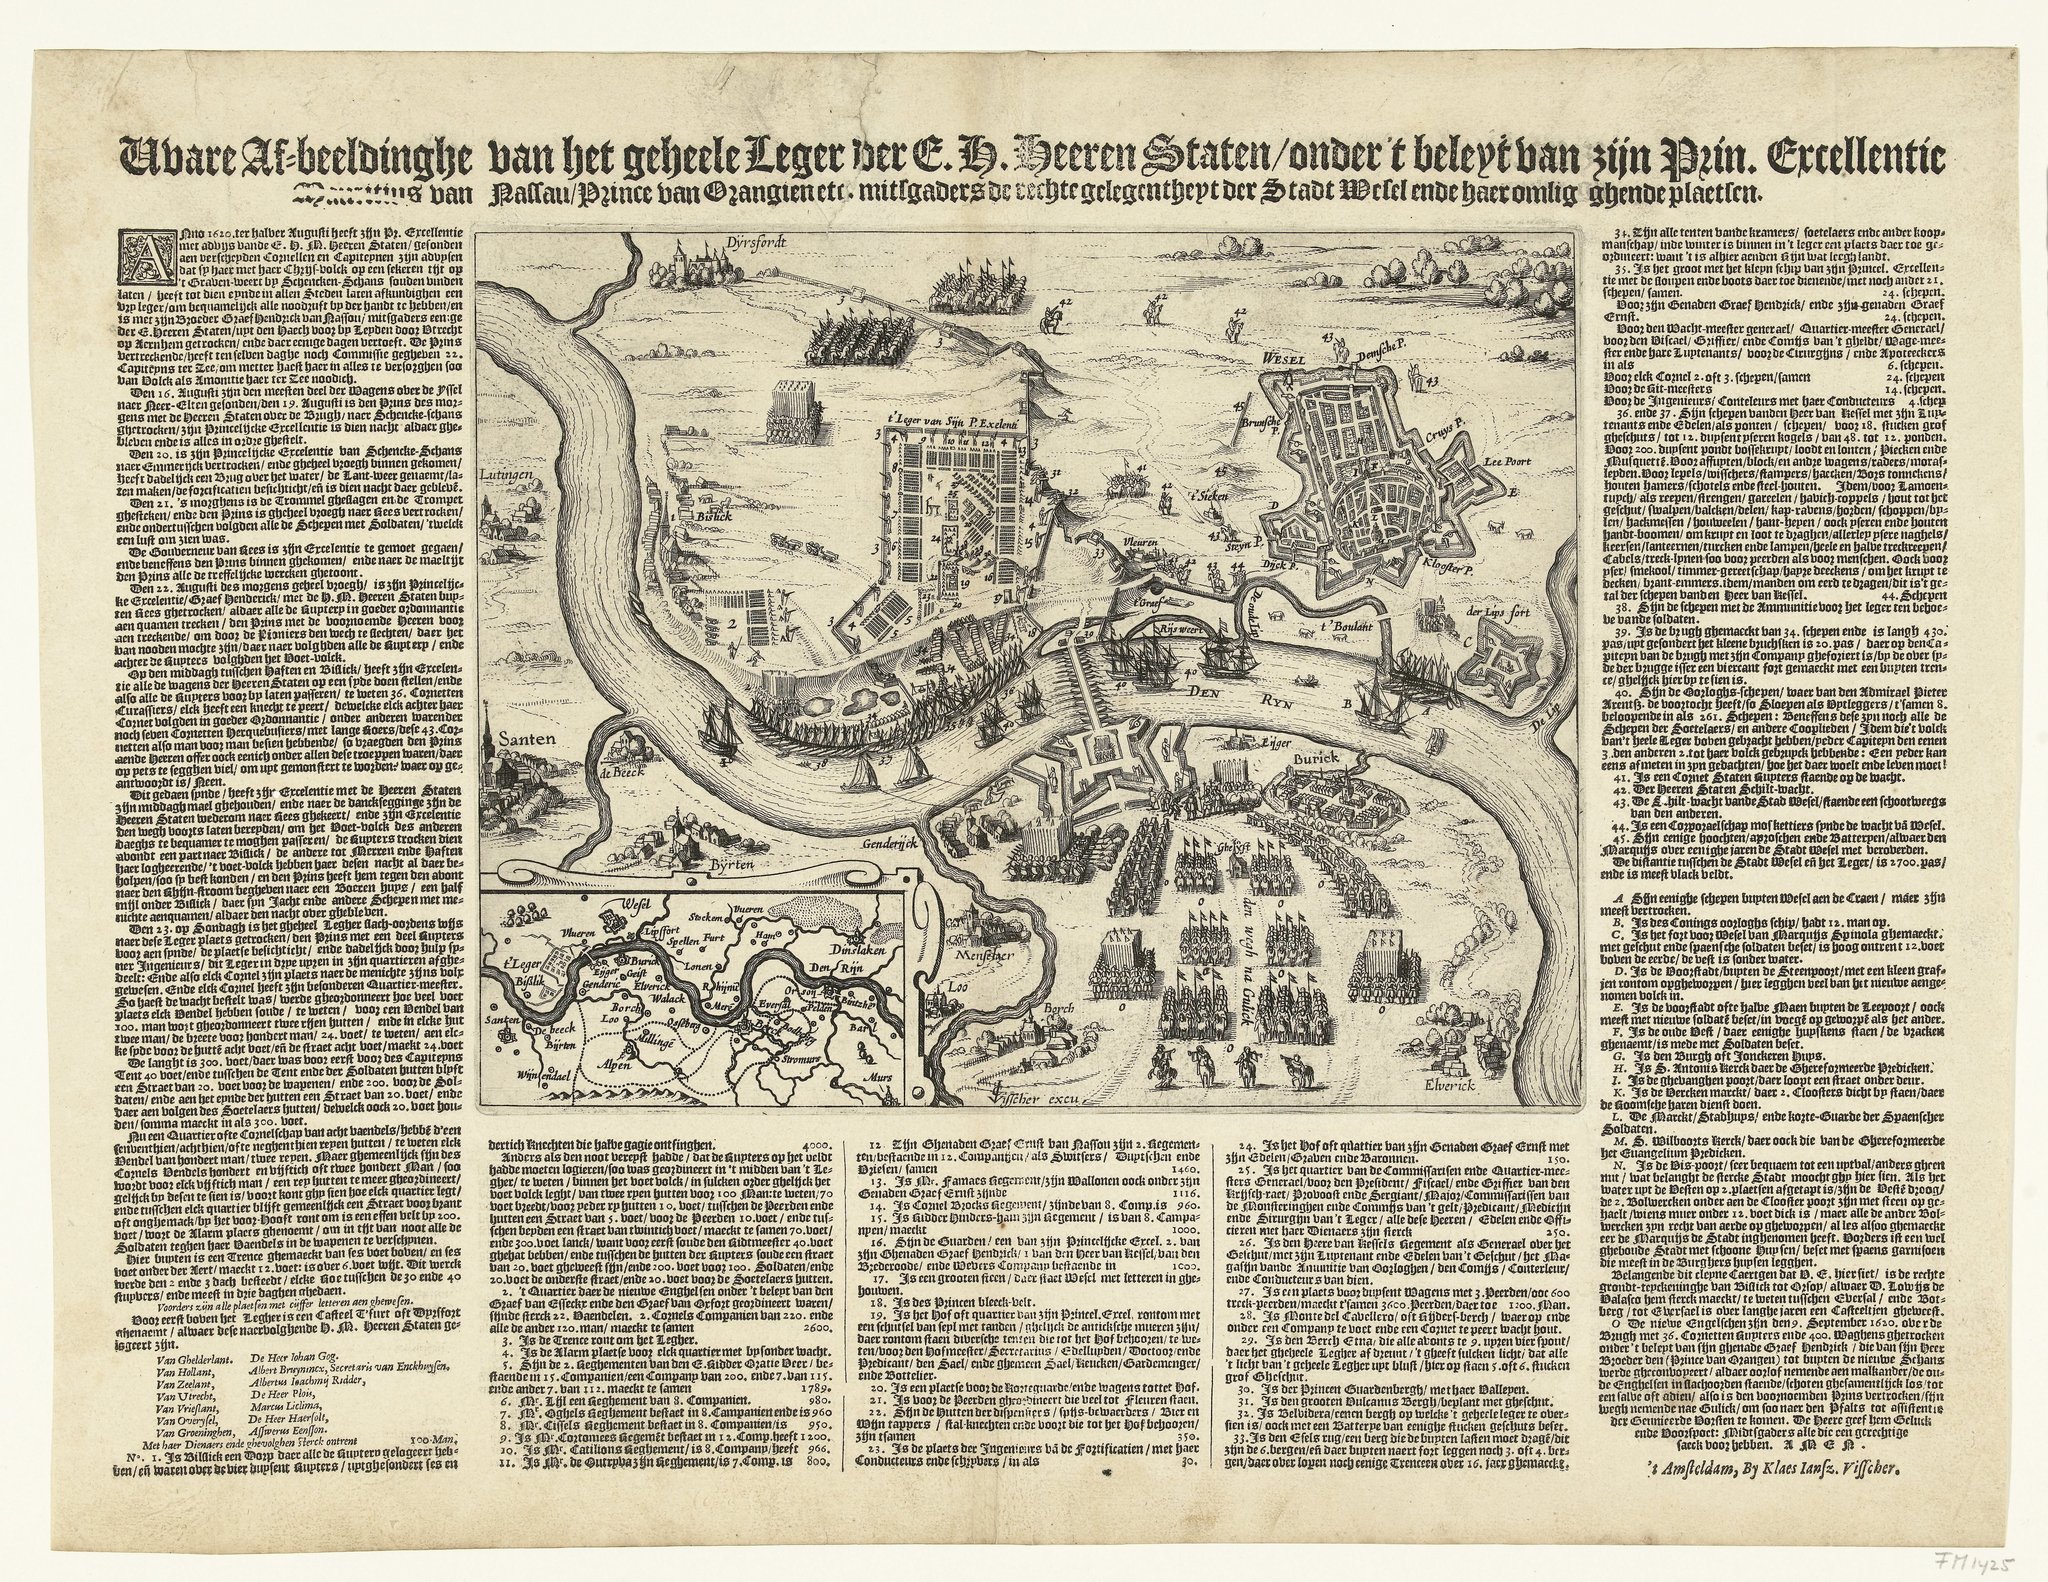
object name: print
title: Het Staatse leger onder Maurits gelegerd bij Wesel, 1620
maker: claes jansz. visscher (ii)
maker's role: draughtsman, print maker, publisher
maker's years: 1586-1652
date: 1620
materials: paper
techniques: etching, letterpress printing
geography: amsterdam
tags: the hague, maurice (prince of orange), troop movements, transportation, maps of separate countries or regions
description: Kaart van Wesel aan de Rijn en omgeving met de legerplaats van het Staatse leger onder Maurits, 1620. Tocht van prins Maurits tegen Spinola, 15-23 augustus 1620. Linksonder een inzet met een kaartje van Rijnland. Om de voorstelling heen een gedrukte beschrijving in 5 kolommen.